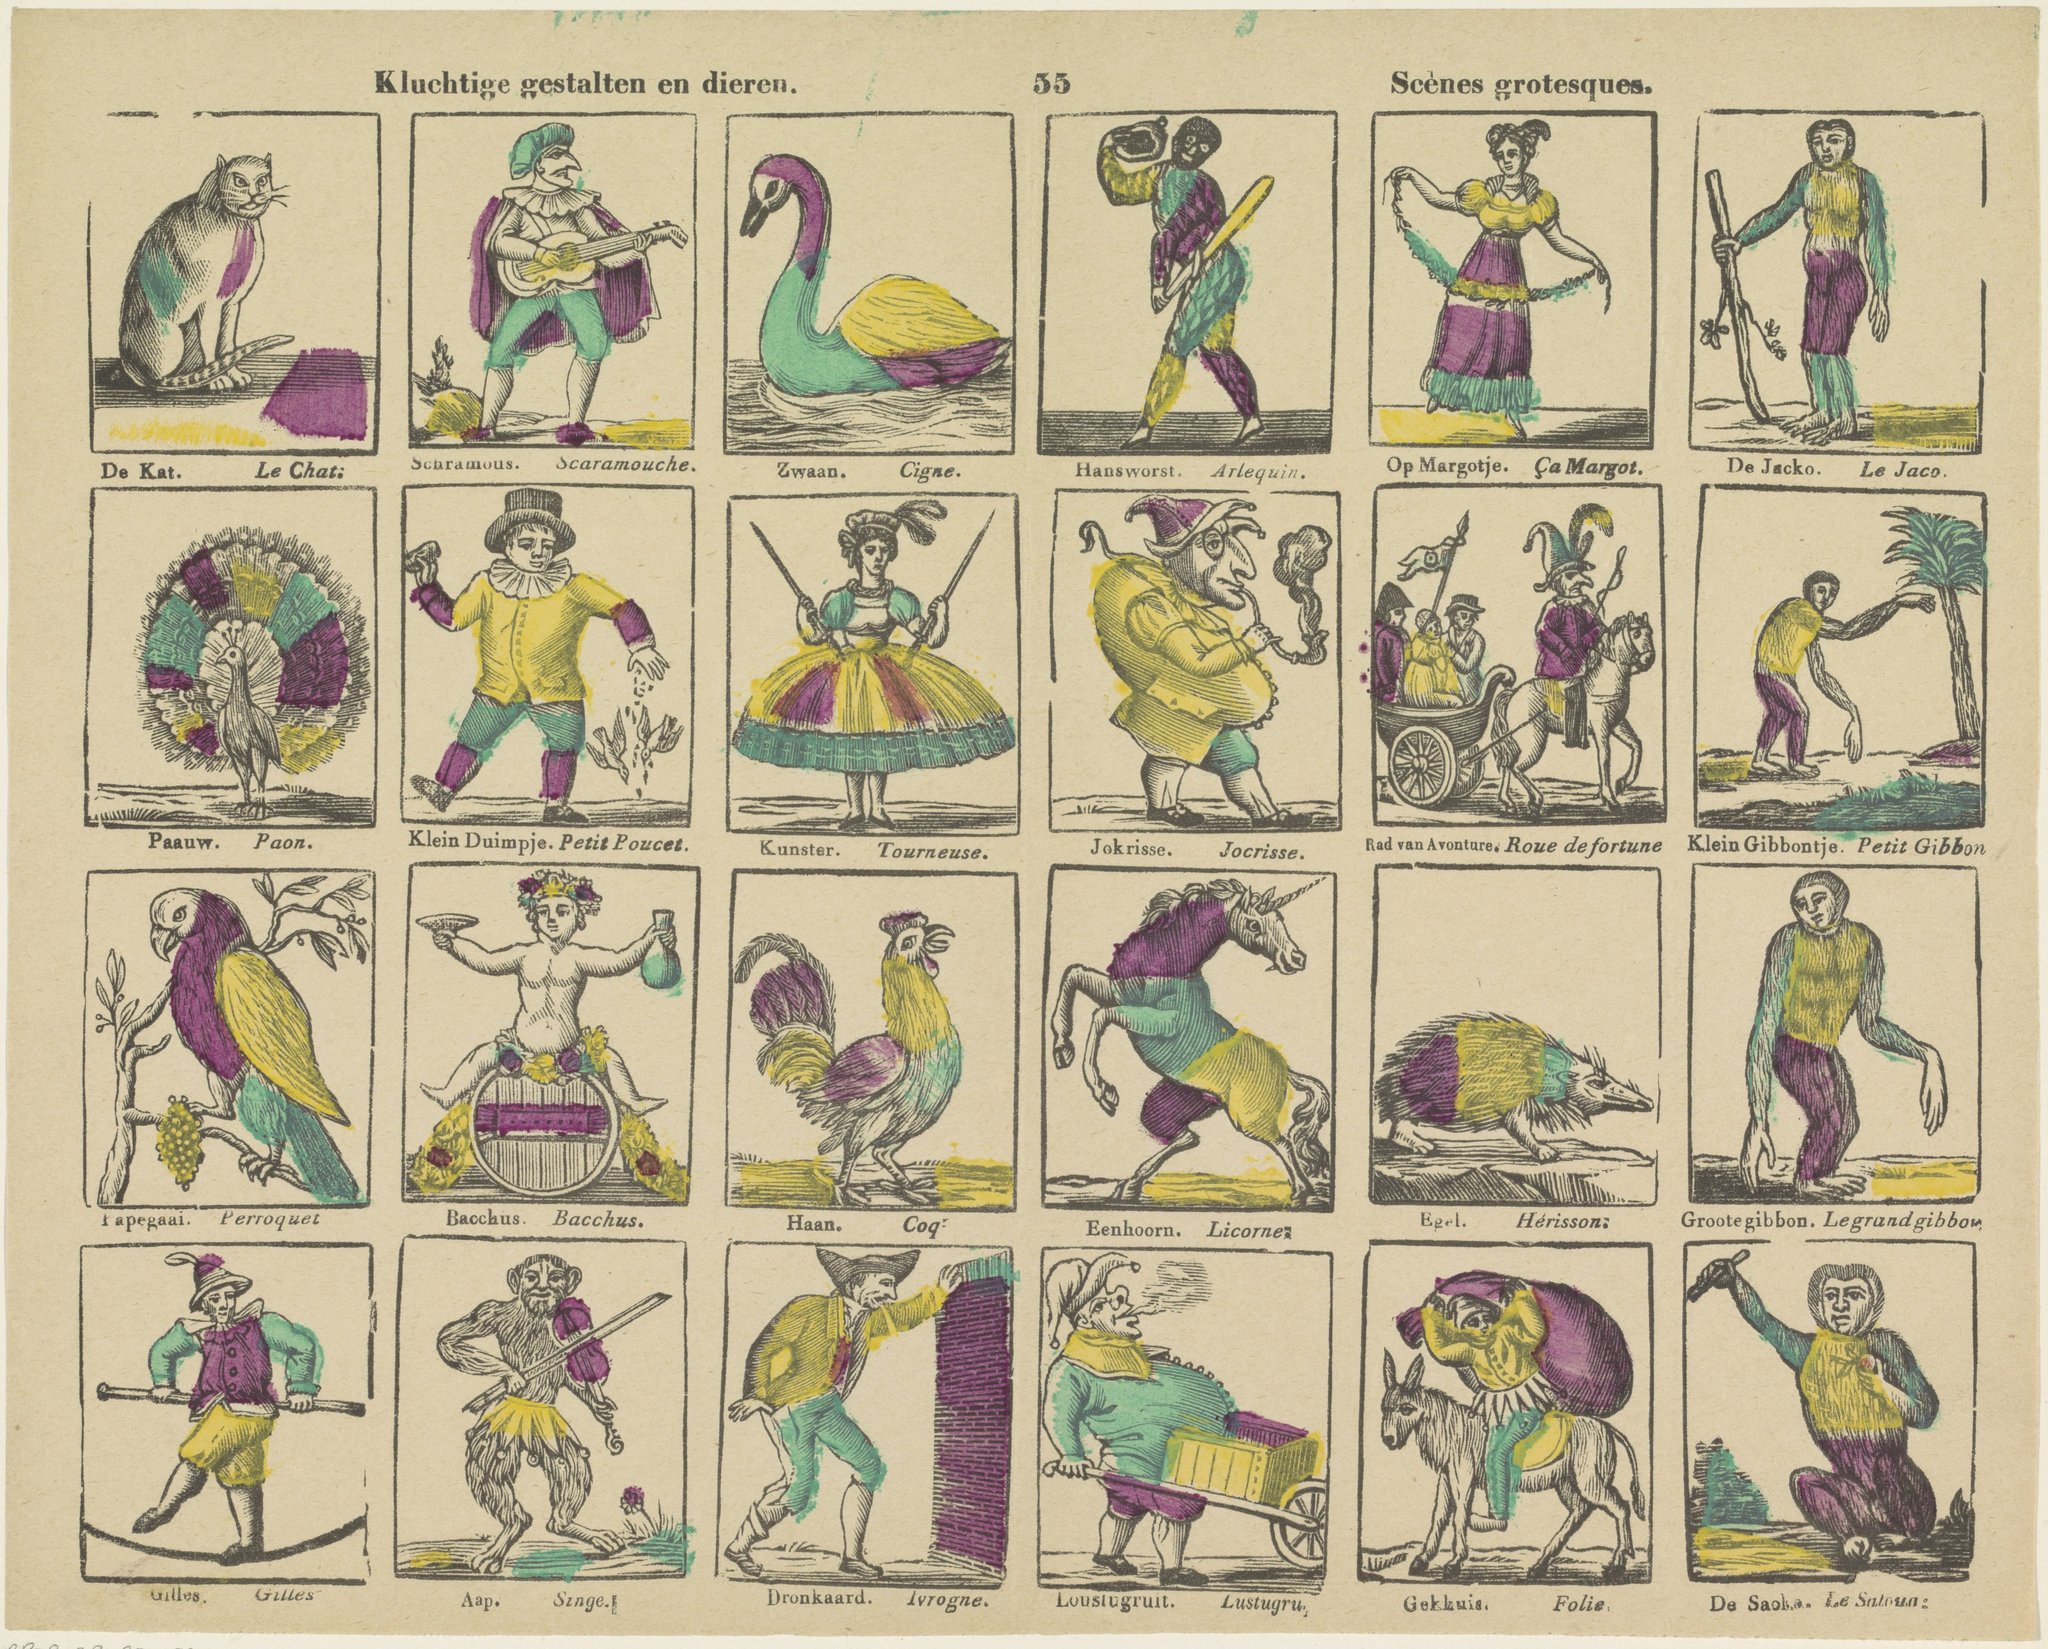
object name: popular print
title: Kluchtige gestalten en dieren / Scènes grotesques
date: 1800-1833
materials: paper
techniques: colour, letterpress printing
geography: turnhout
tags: animals, drunkard, characters (human types), tales and fairy tales: little thumbling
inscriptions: collector's mark: Lugt 2760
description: Blad met 24 voorstellingen van dieren en figuren, waaronder een zwaan, Klein Duimpje en een aap. Onder elke afbeelding een onderschrift in het Nederlands en in het Frans. Genummerd midden boven: 55.